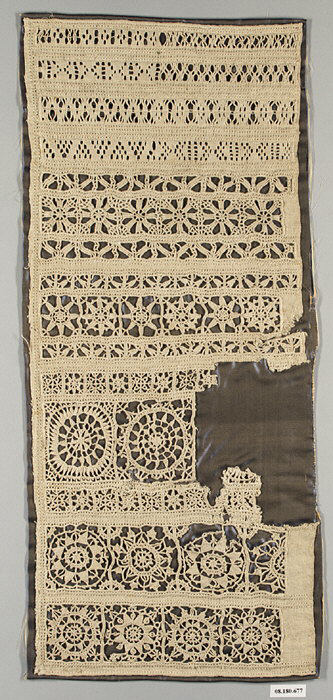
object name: fragment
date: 1701-1800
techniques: lace